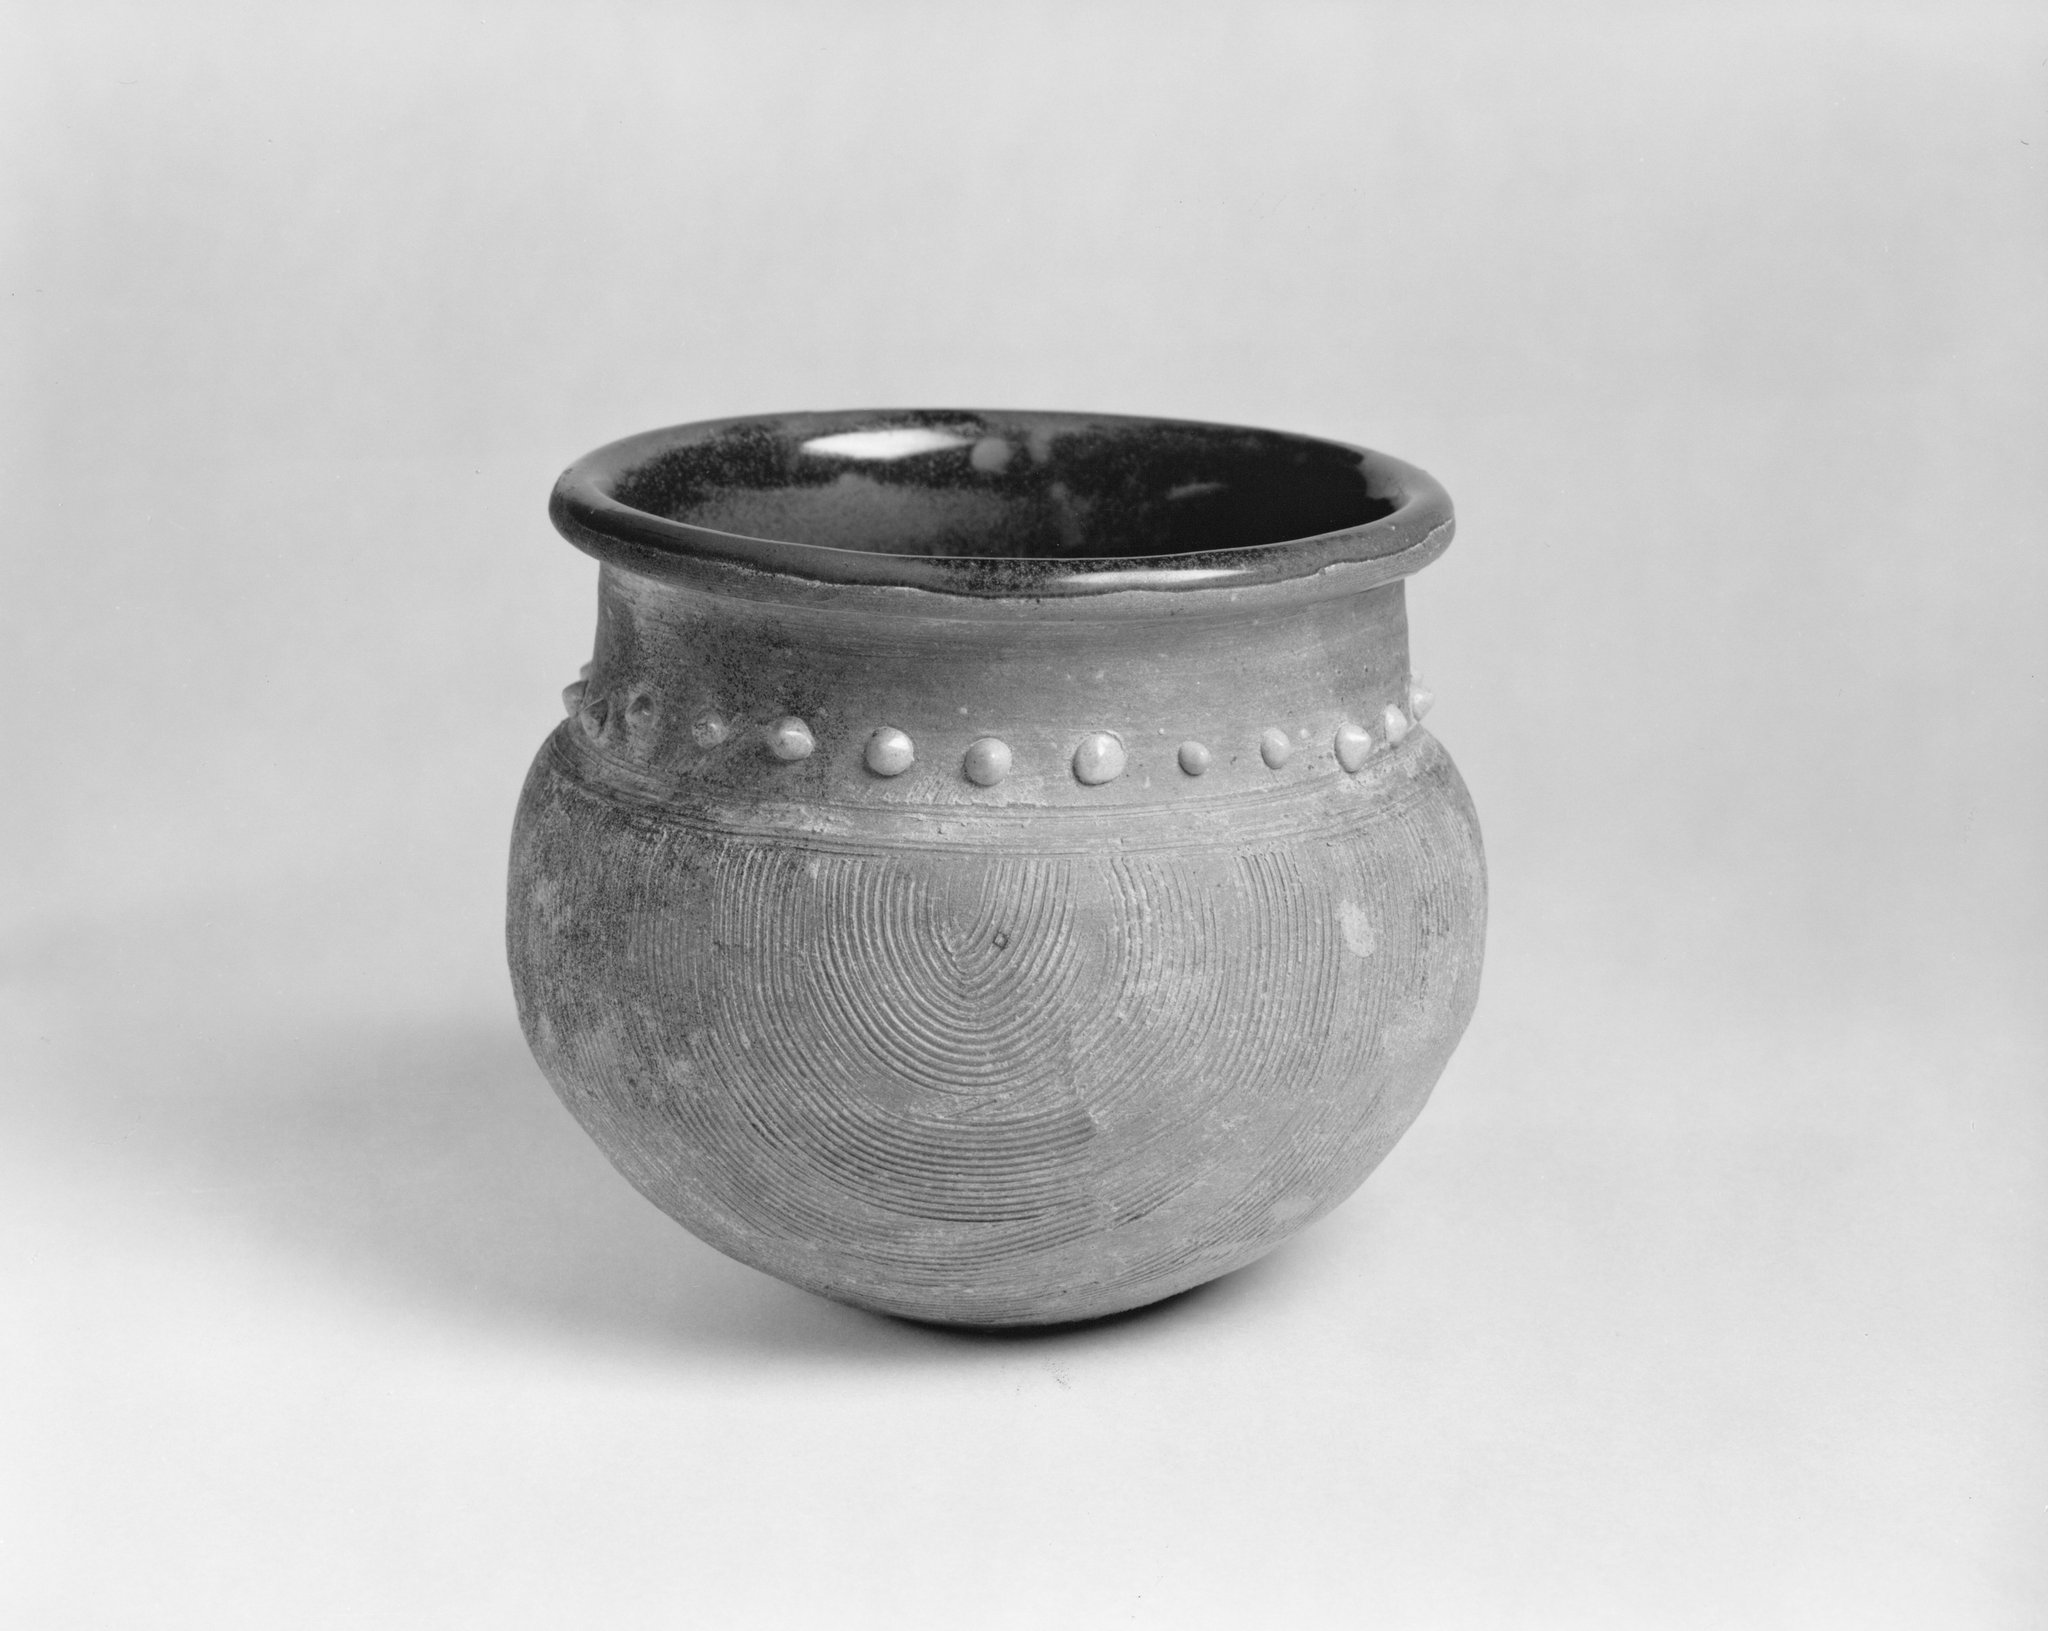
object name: jar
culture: chinese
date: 1101-1400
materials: biscuit, glaze, stoneware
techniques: incising